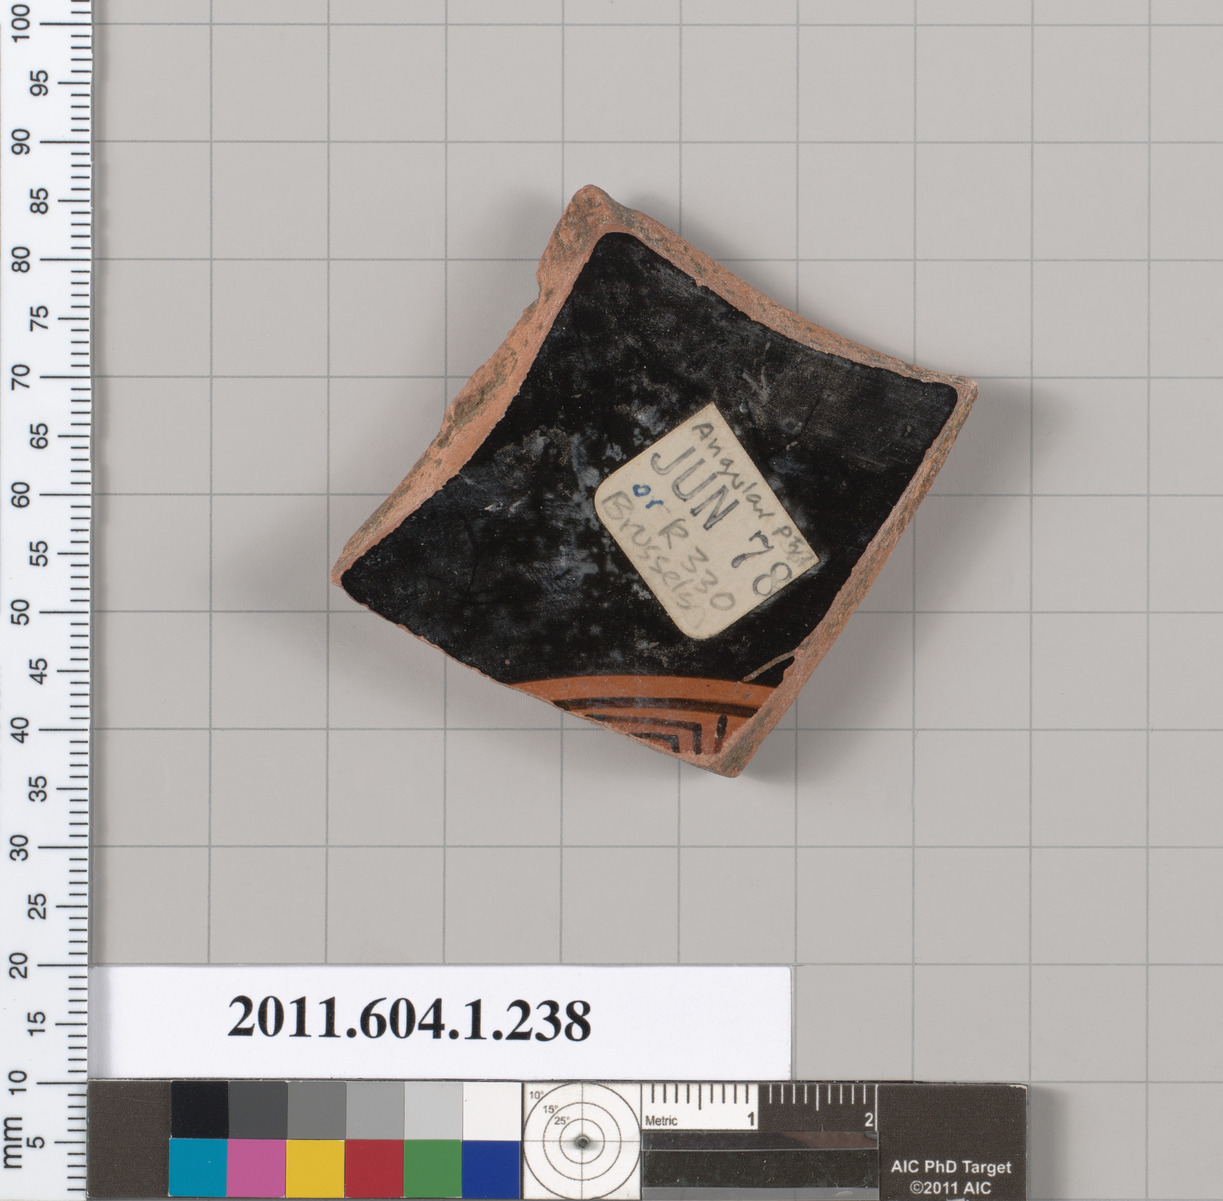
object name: kylix fragment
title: Terracotta fragment of a kylix (drinking cup)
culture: greek, attic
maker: angular painter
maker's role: artist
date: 475-451 BCE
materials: terracotta